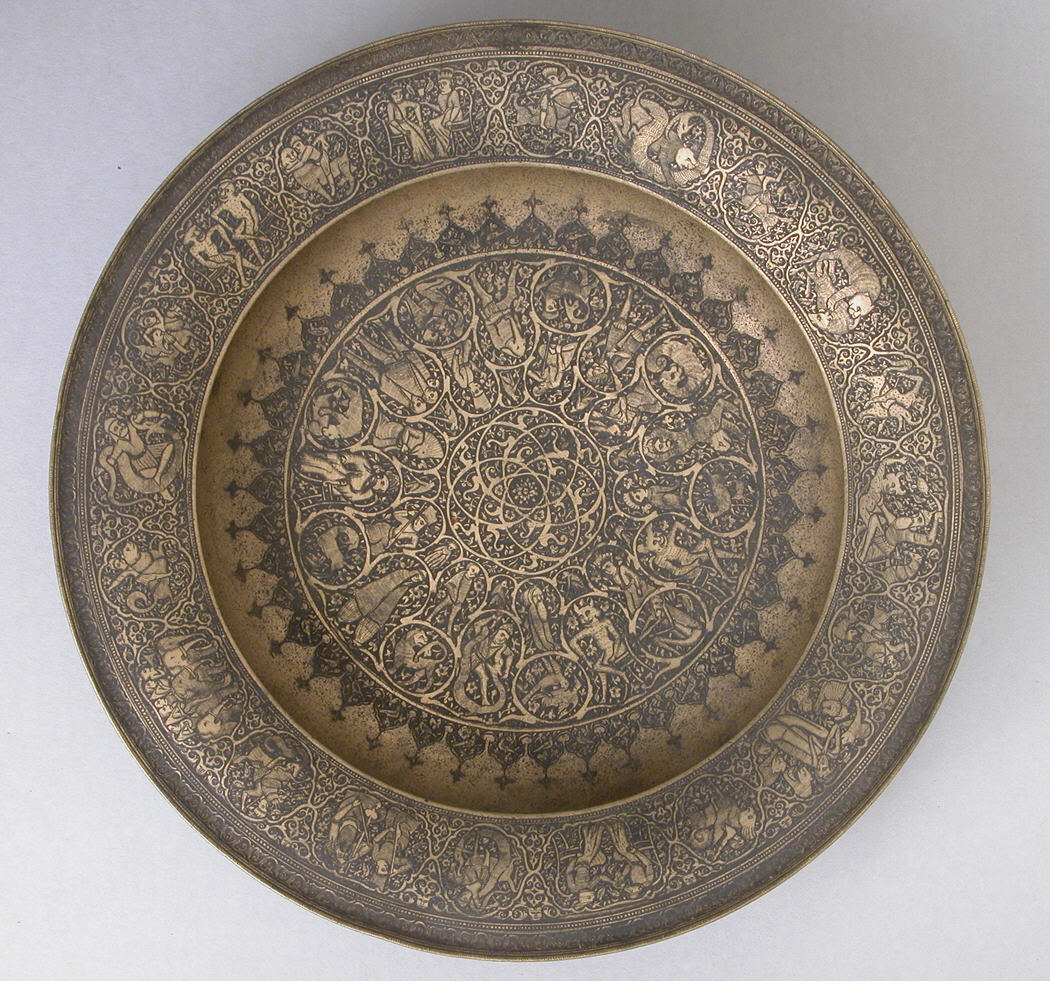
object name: basin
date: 1701-1900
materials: brass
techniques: engraving, inlay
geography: iran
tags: human figures,animals